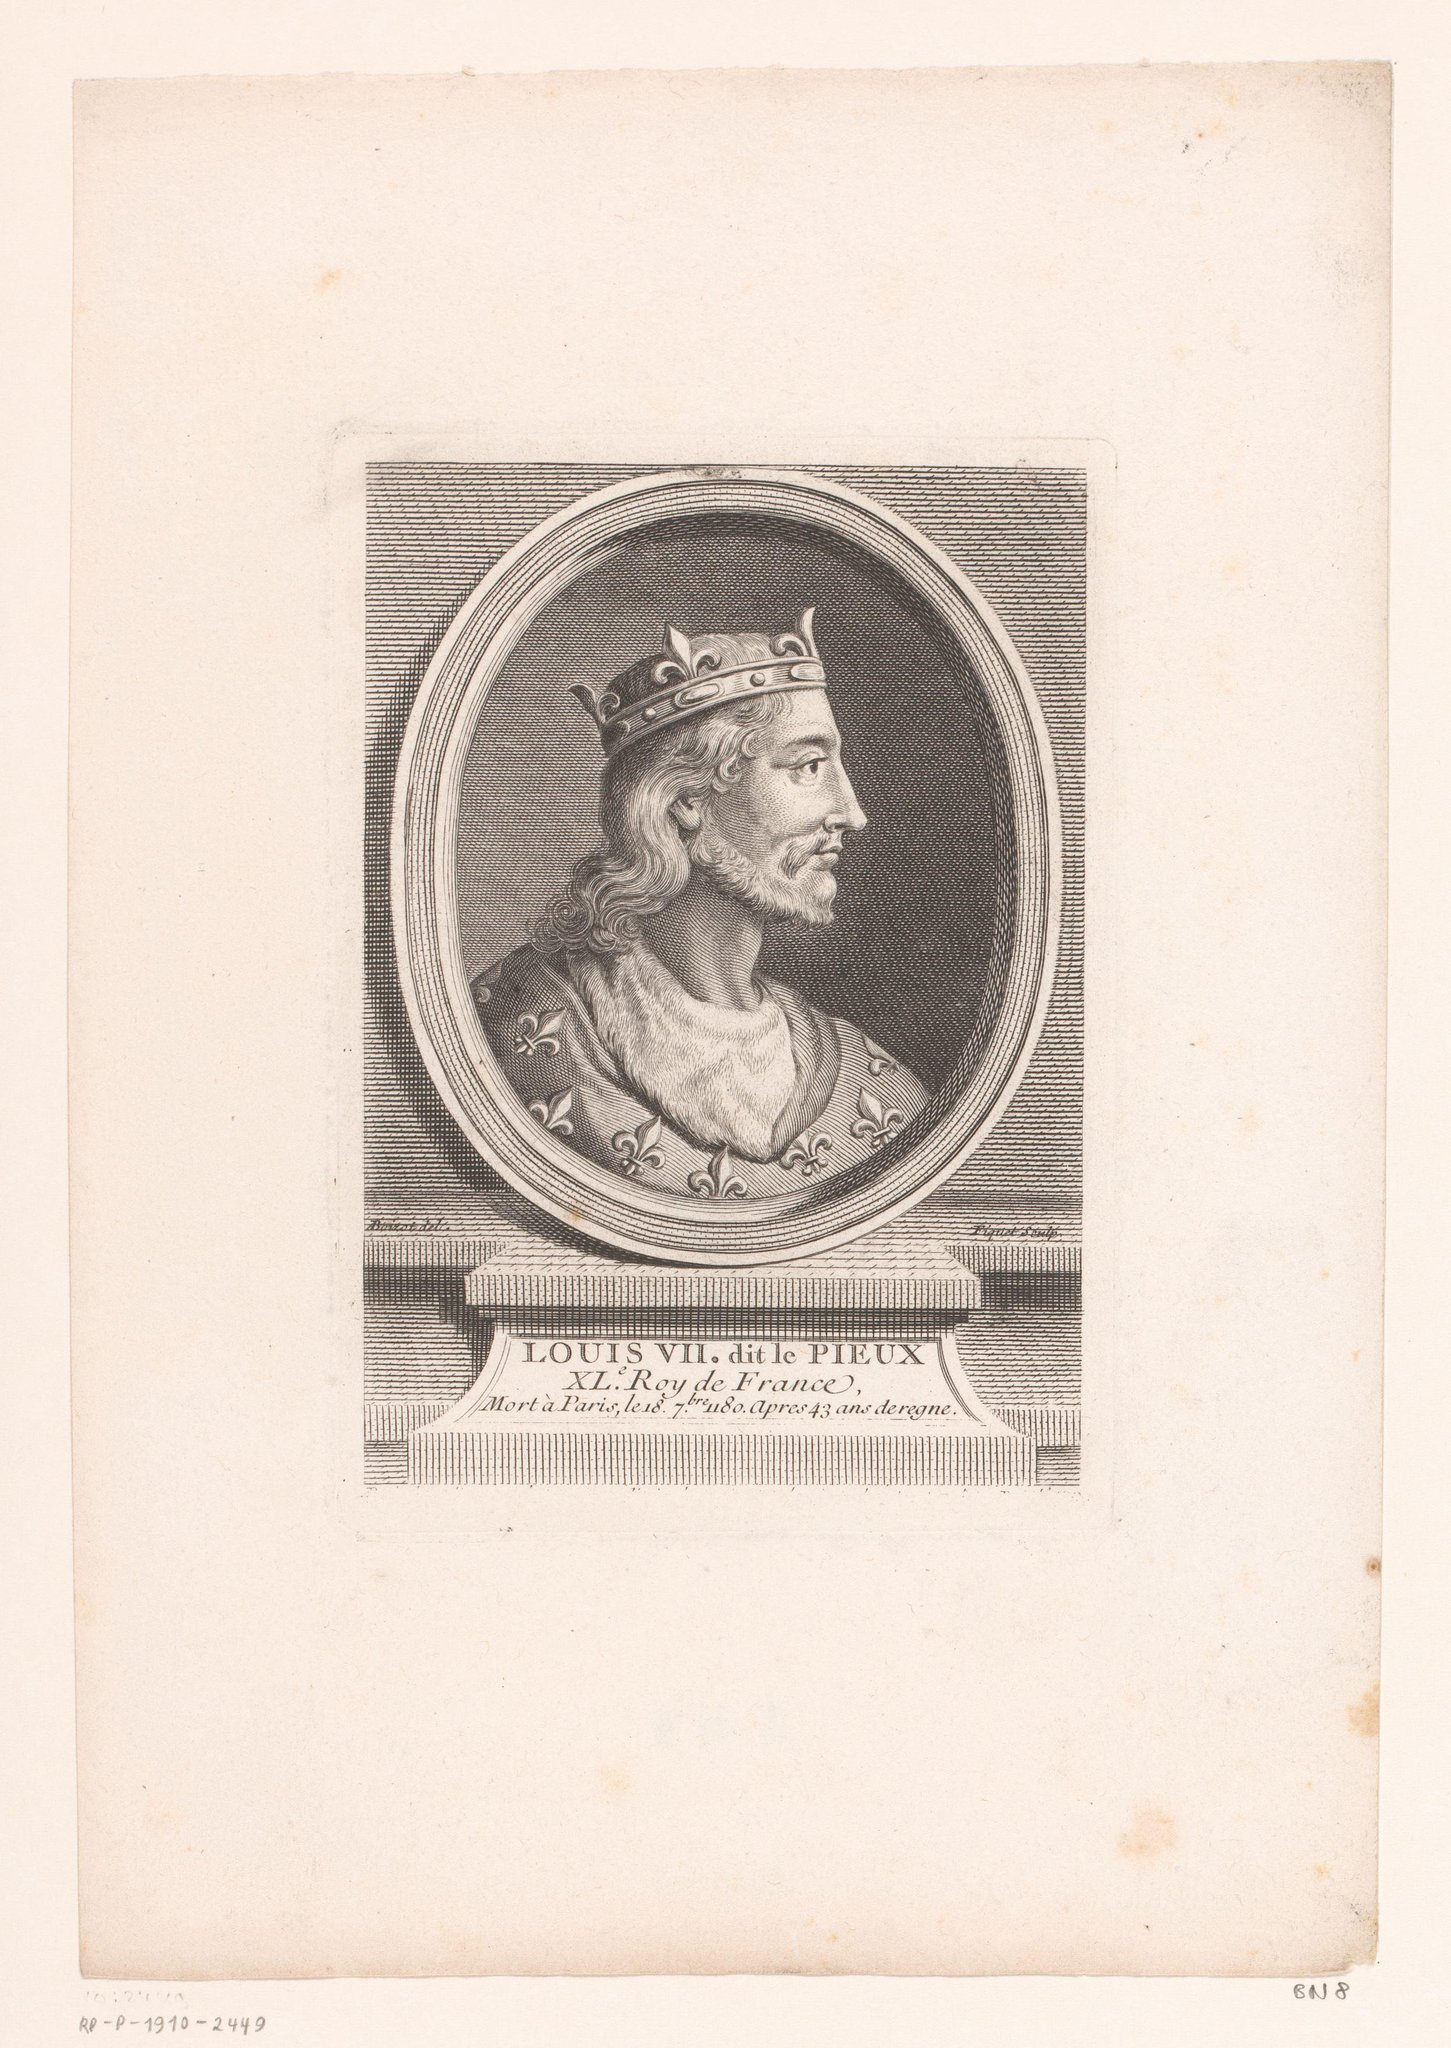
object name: print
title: Louis VII. dit le pieux XIe. Roi de France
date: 1742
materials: paper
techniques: engraving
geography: france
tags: paris, ornament ~ medallion, historical persons, ruler, sovereign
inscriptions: collector's mark: Lugt 2228